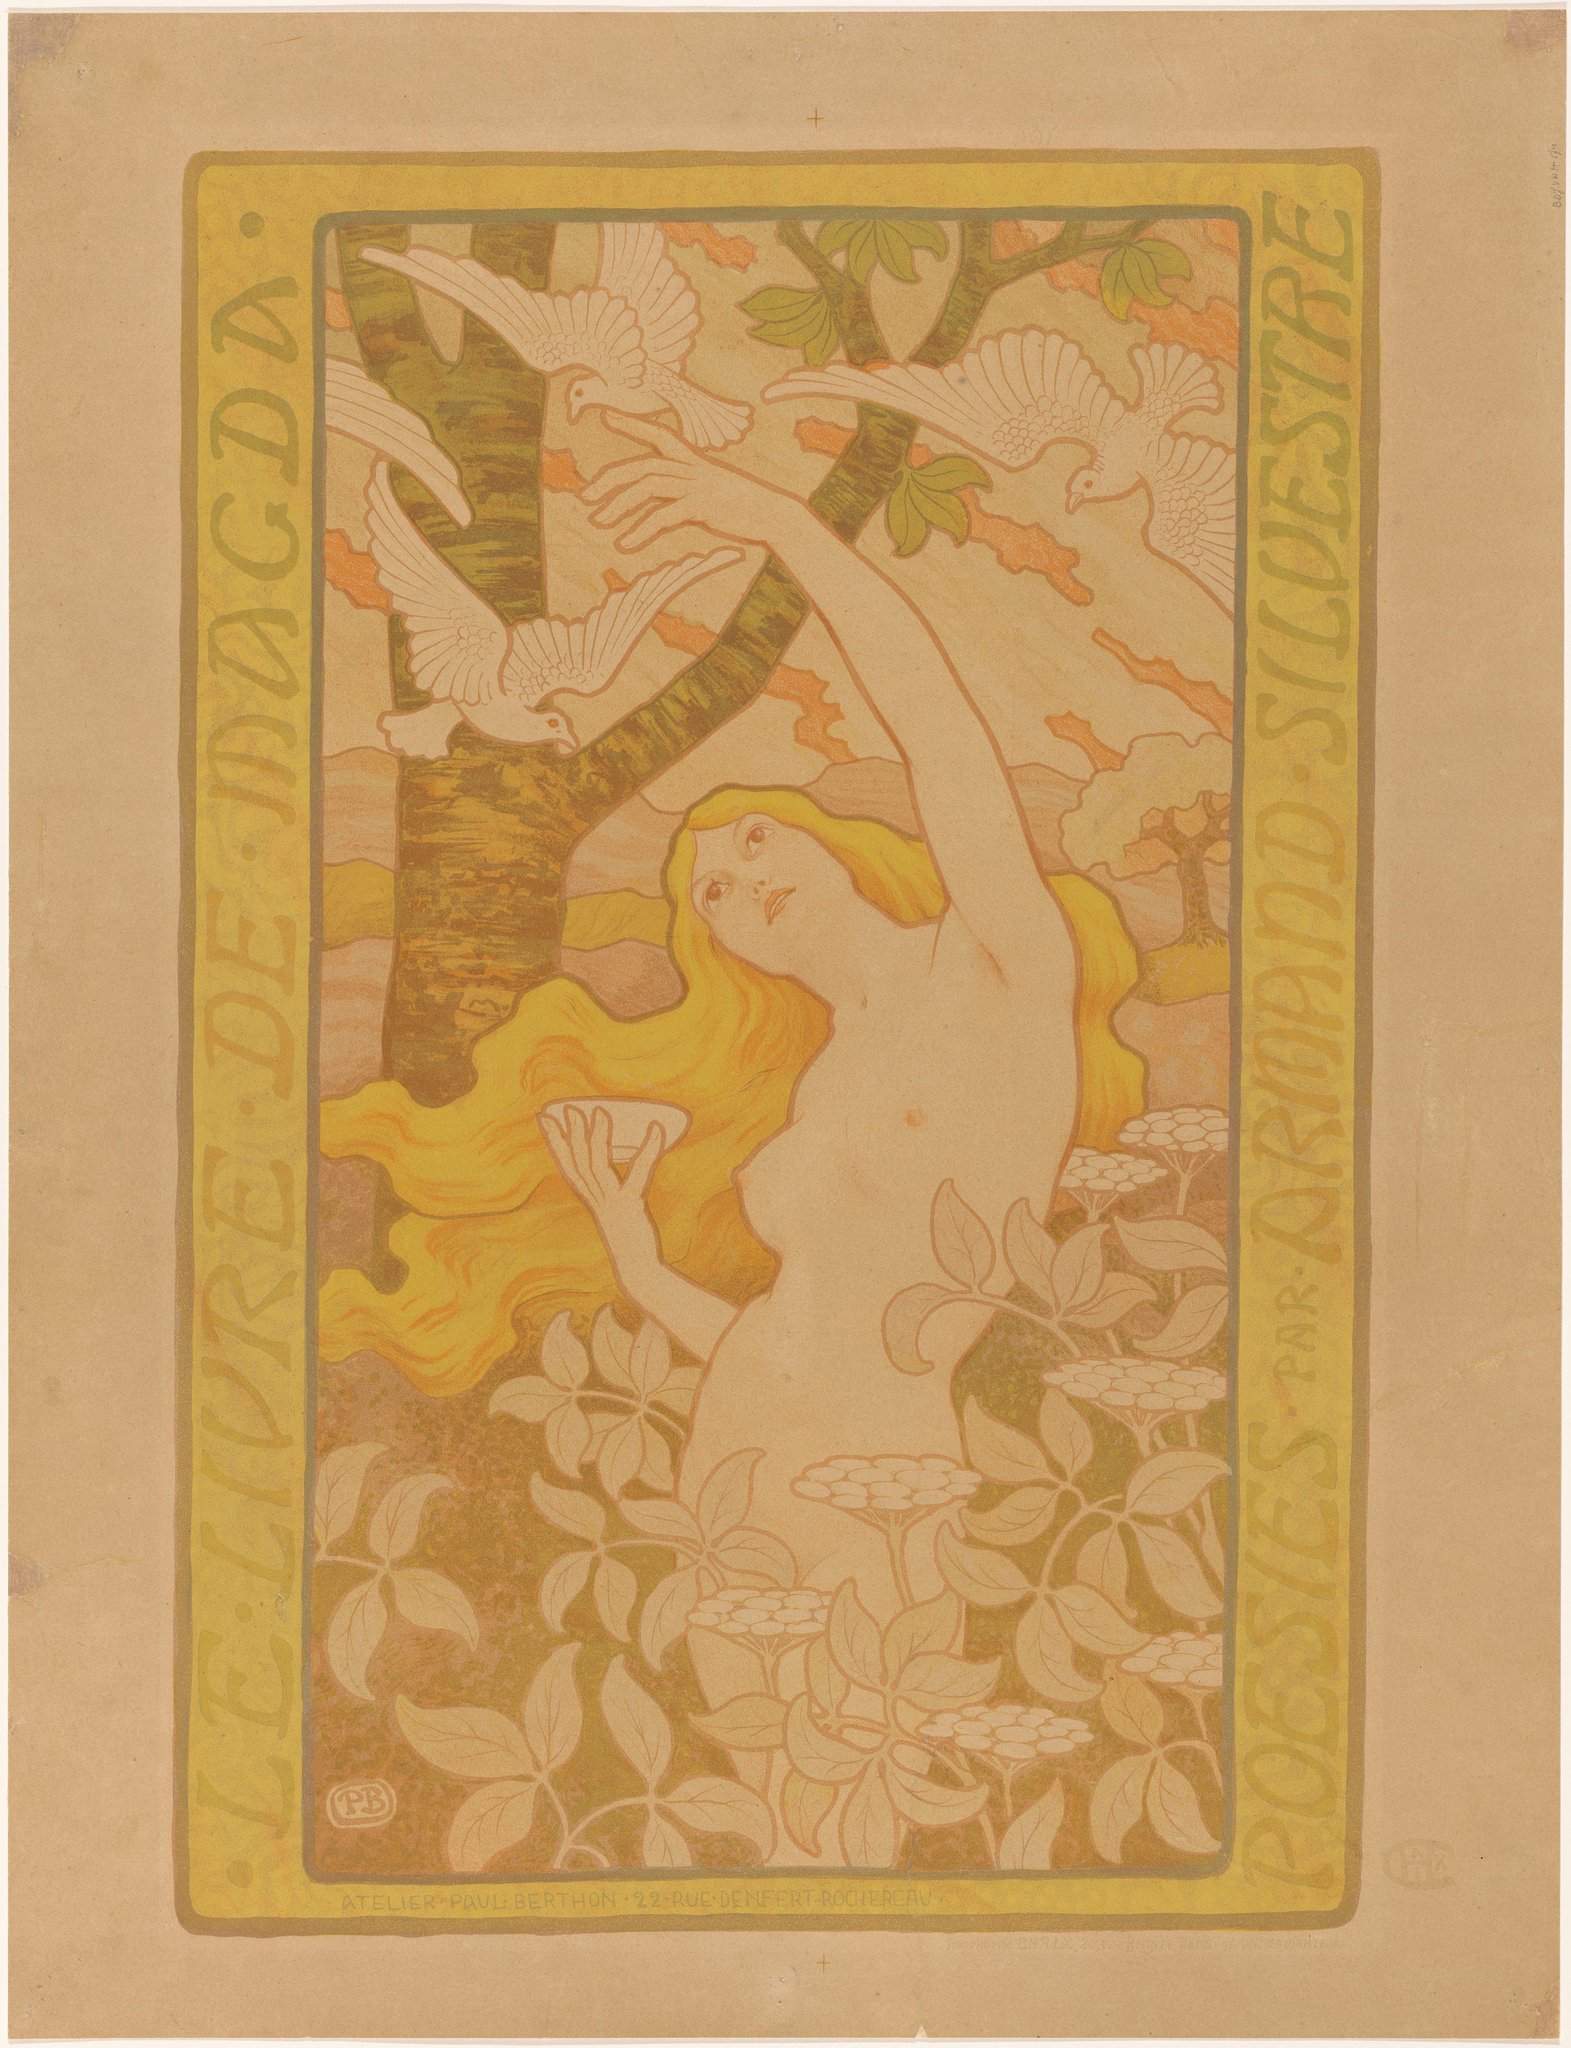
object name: print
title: Affiche voor Le livre de Magda door Armand Silvestre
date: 1898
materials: paper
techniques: lithograph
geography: france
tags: (hama)dryads, forest- and tree-nymphs; 'driadi & hamadriadi' (ripa), doves, pigeons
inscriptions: collector's mark: Lugt 4779, collector's mark: Lugt 2228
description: Tussen de struiken staat een bosnimf met in haar rechterhand een schotel. Ze heeft haar linkerhand uitgestrekt naar de duiven die boven haar vliegen.